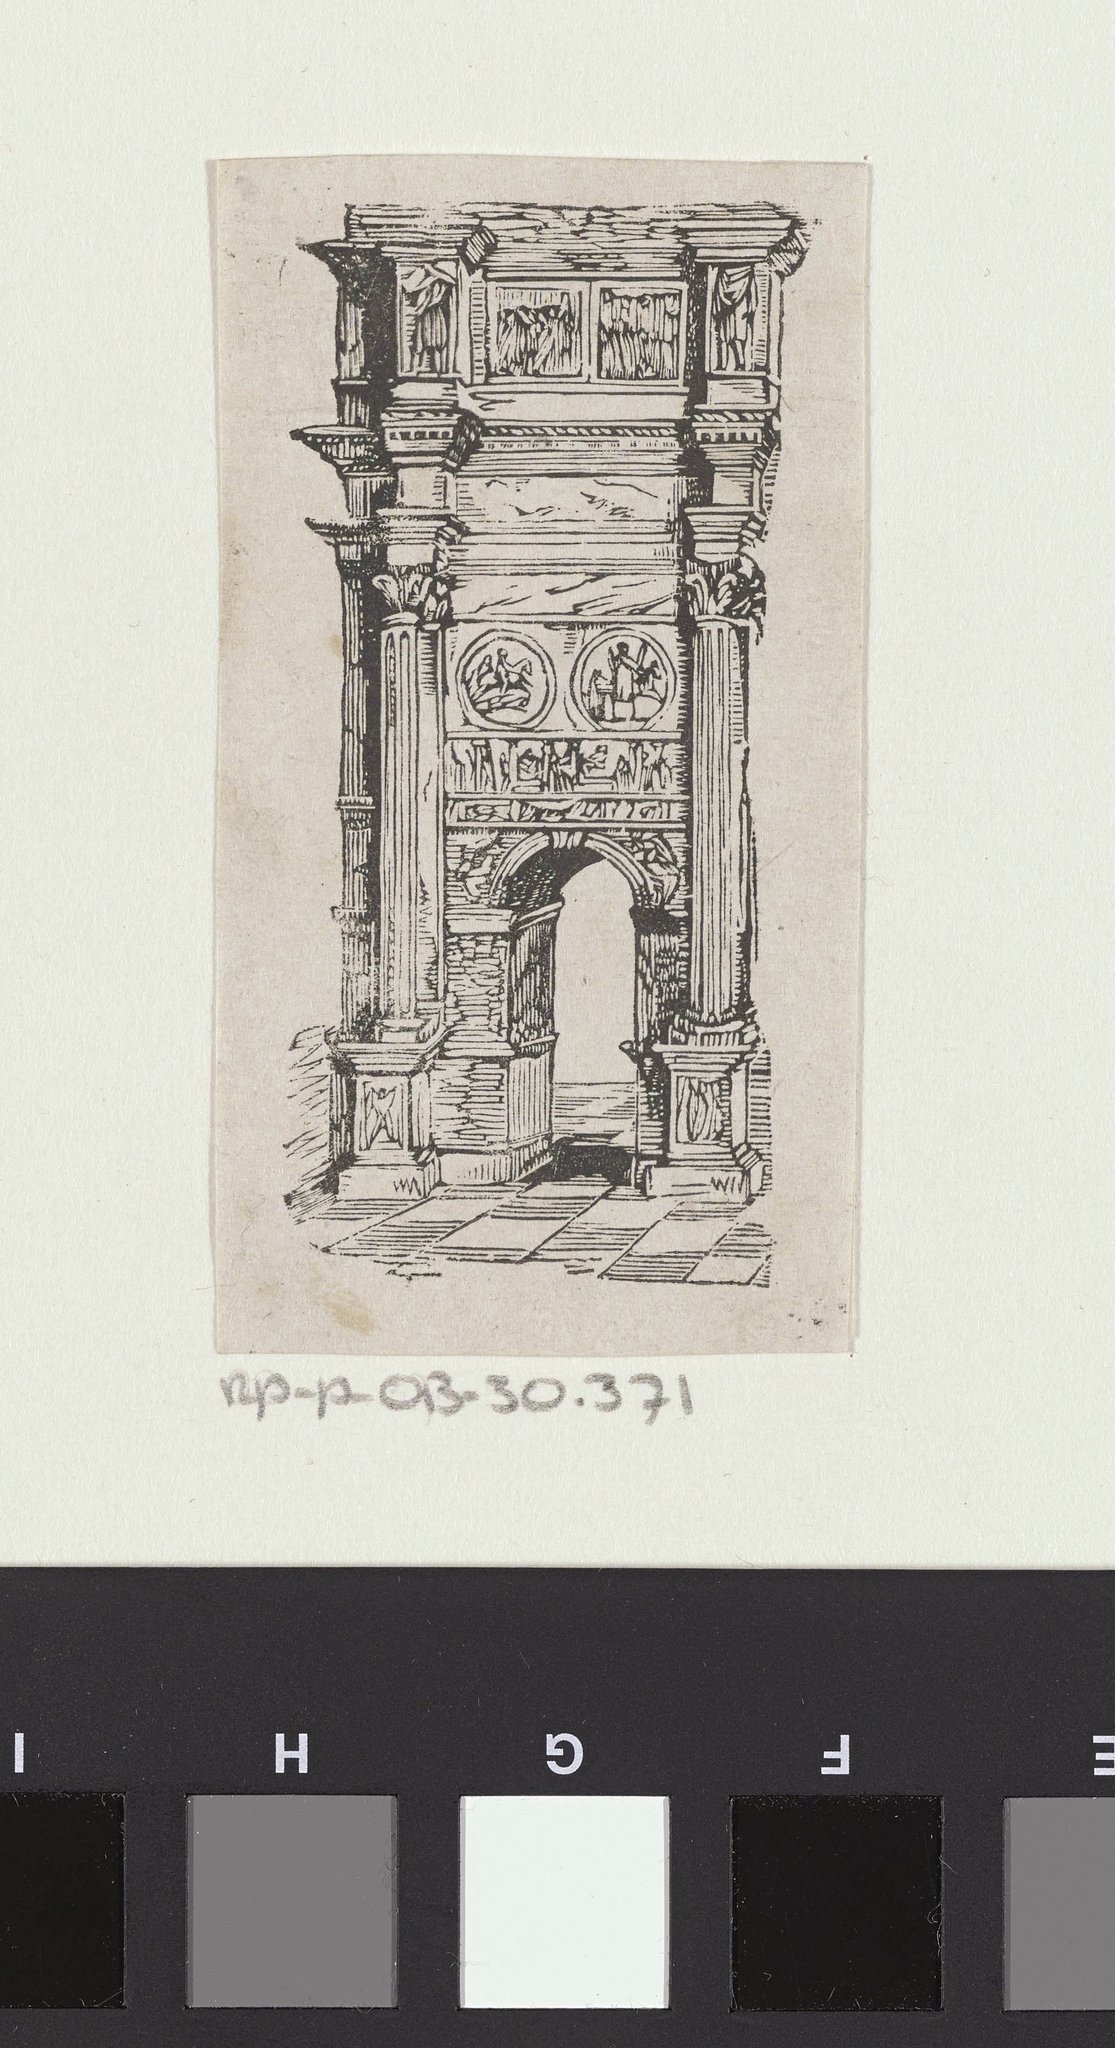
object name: print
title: Monumentale boog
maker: isaac weissenbruch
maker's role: print maker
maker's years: 1826-1912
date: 1836-1912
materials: paper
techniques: engraving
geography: netherlands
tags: triumphal arch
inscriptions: collector's mark: Lugt 2228